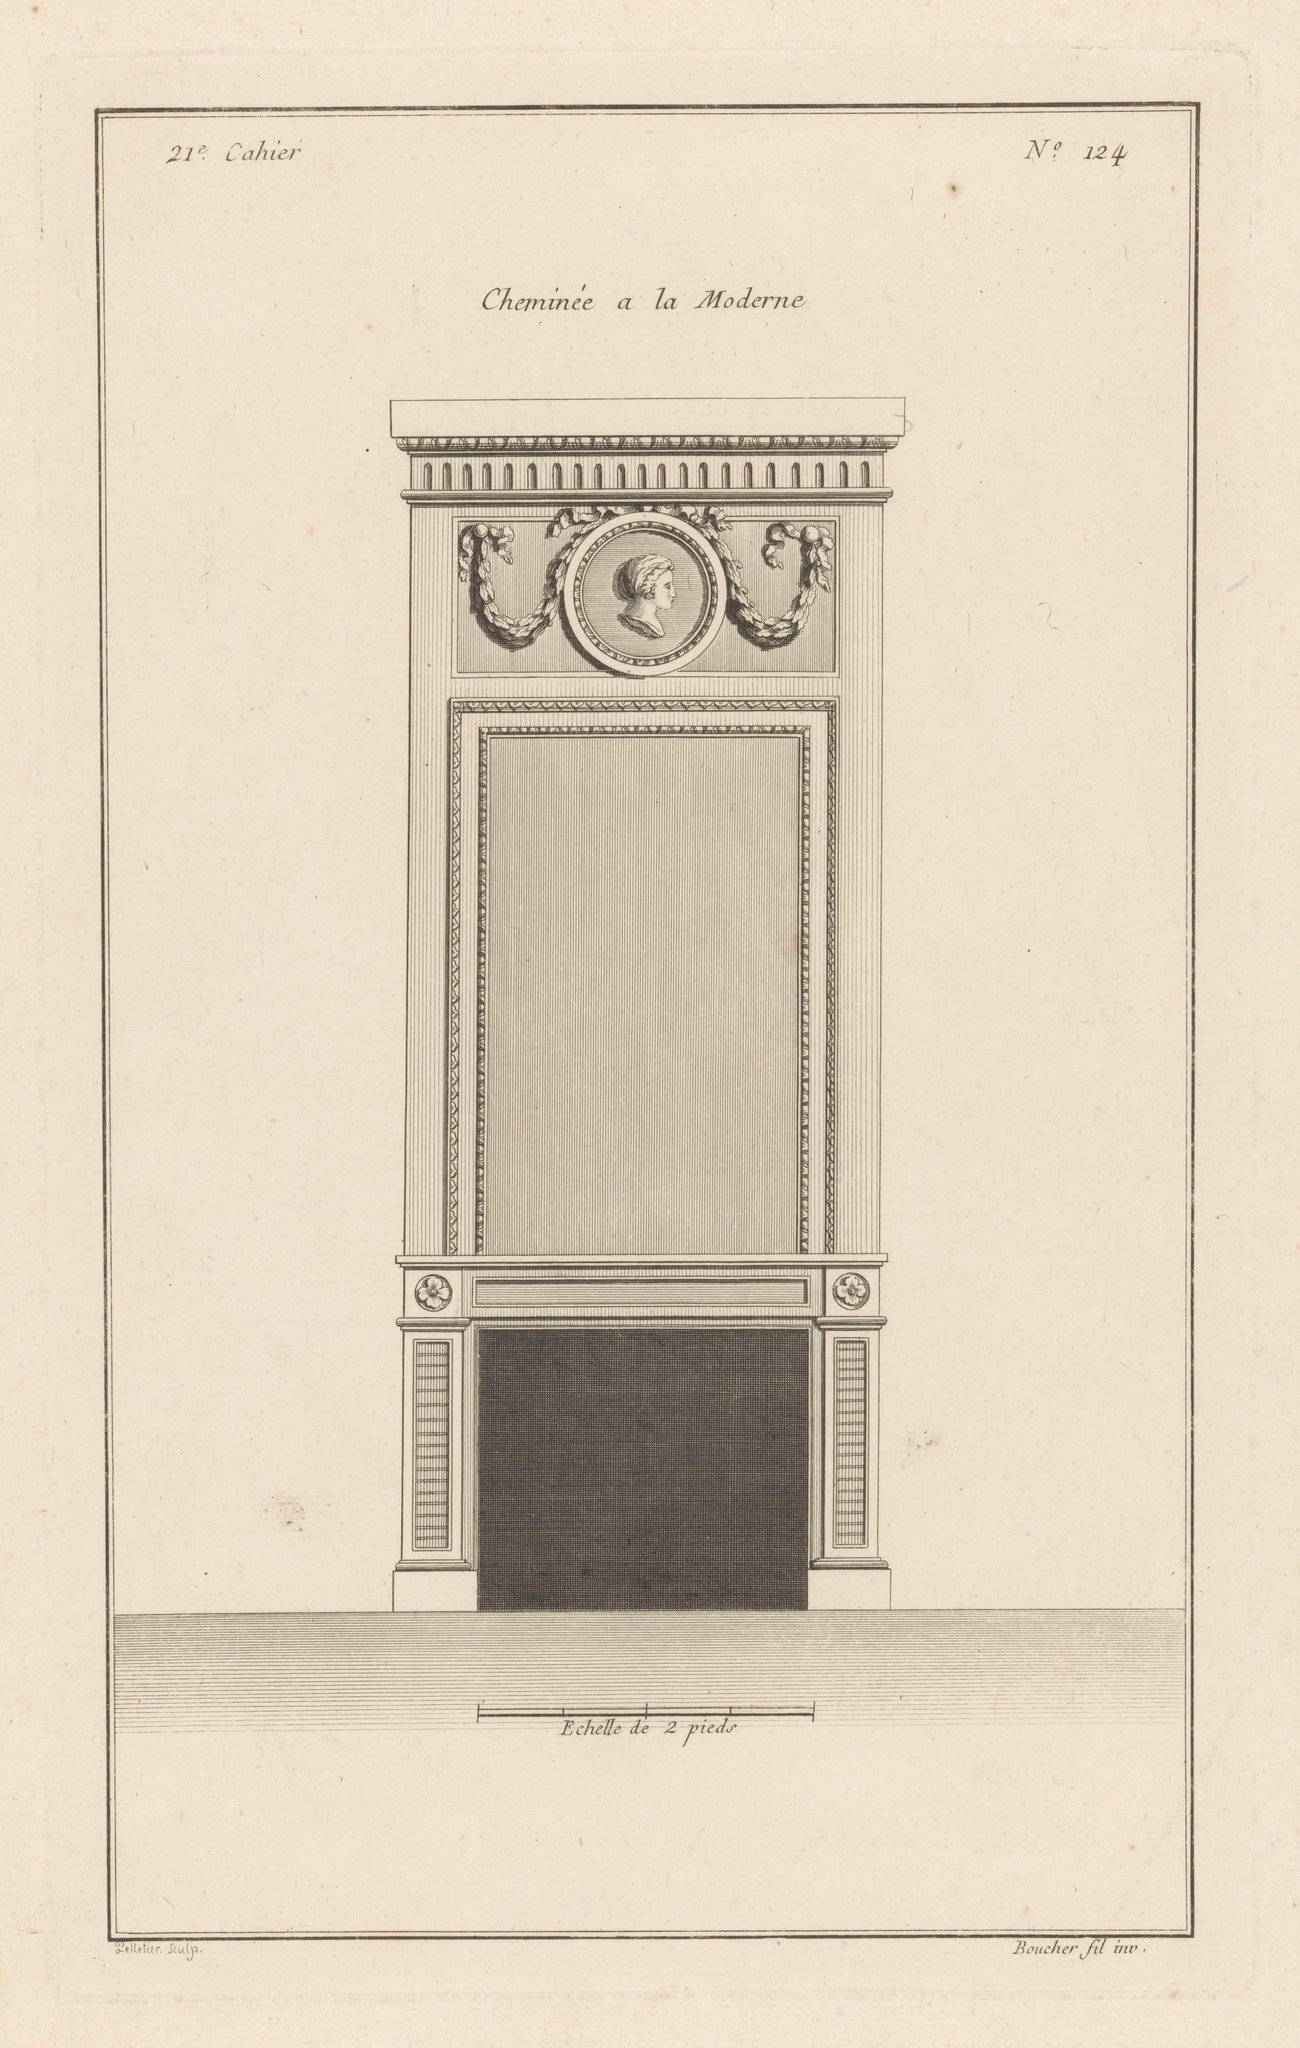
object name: ornament print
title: 21e Cahier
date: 1772-1779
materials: paper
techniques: engraving, etching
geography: paris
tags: ornament ~ medallion, open hearth, fire-place, ornament ~ festoon, garland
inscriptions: collector's mark: Lugt 2228, collector's mark: Lugt 2760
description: Een geornamenteerde schouw met guirlandes en medaillon met portret en profil. Prentnummer 124.